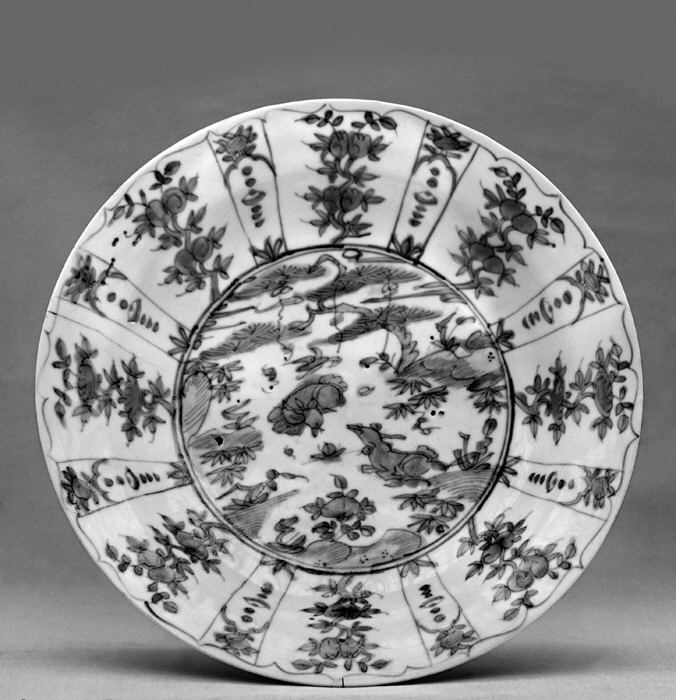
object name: plate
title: Plate with a pair of oxen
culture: chinese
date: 1567-1633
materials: cobalt, porcelain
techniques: painting, underglaze